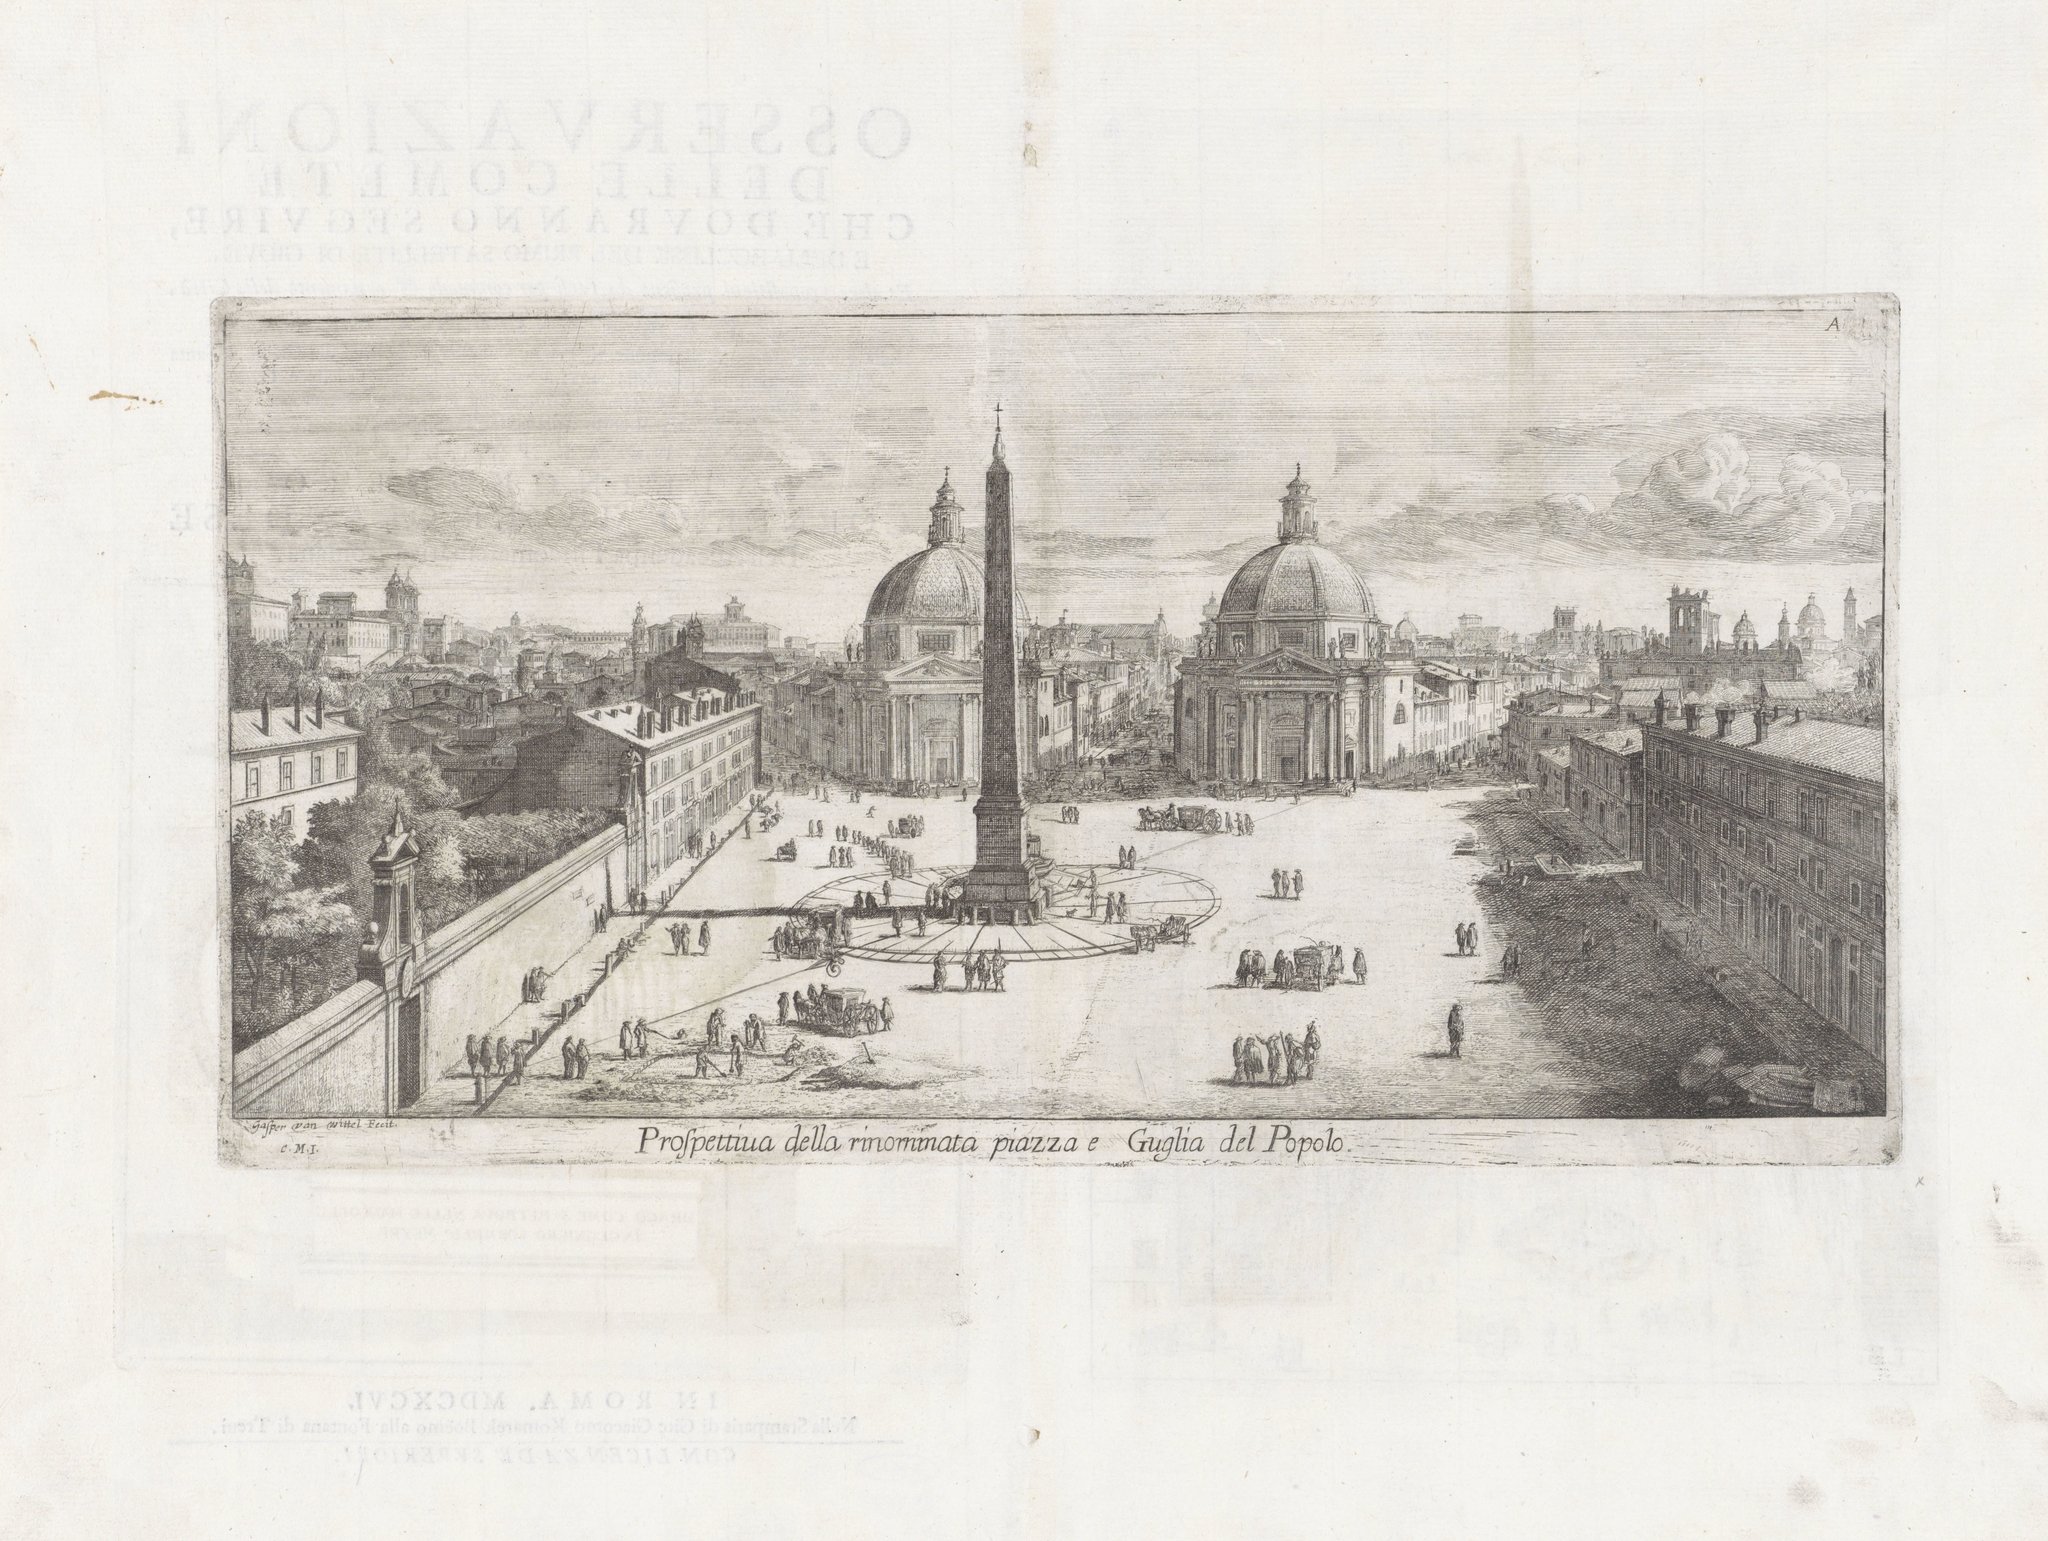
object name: print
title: Porspettiva della rinommata piazza e Guglia del Popolo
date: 1696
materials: paper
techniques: engraving, etching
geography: rome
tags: city-view, and landscape with man-made constructions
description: De prent is ook als boekillustratie gebruikt in: Meijer, Cornelis, L'arte di rendere i fiumi navigabili in varij modi, con altre nuove inventioni e varij altri segreti, Rome: Stamperio di Gio. Giacomo Komarek Boëmo, 1696